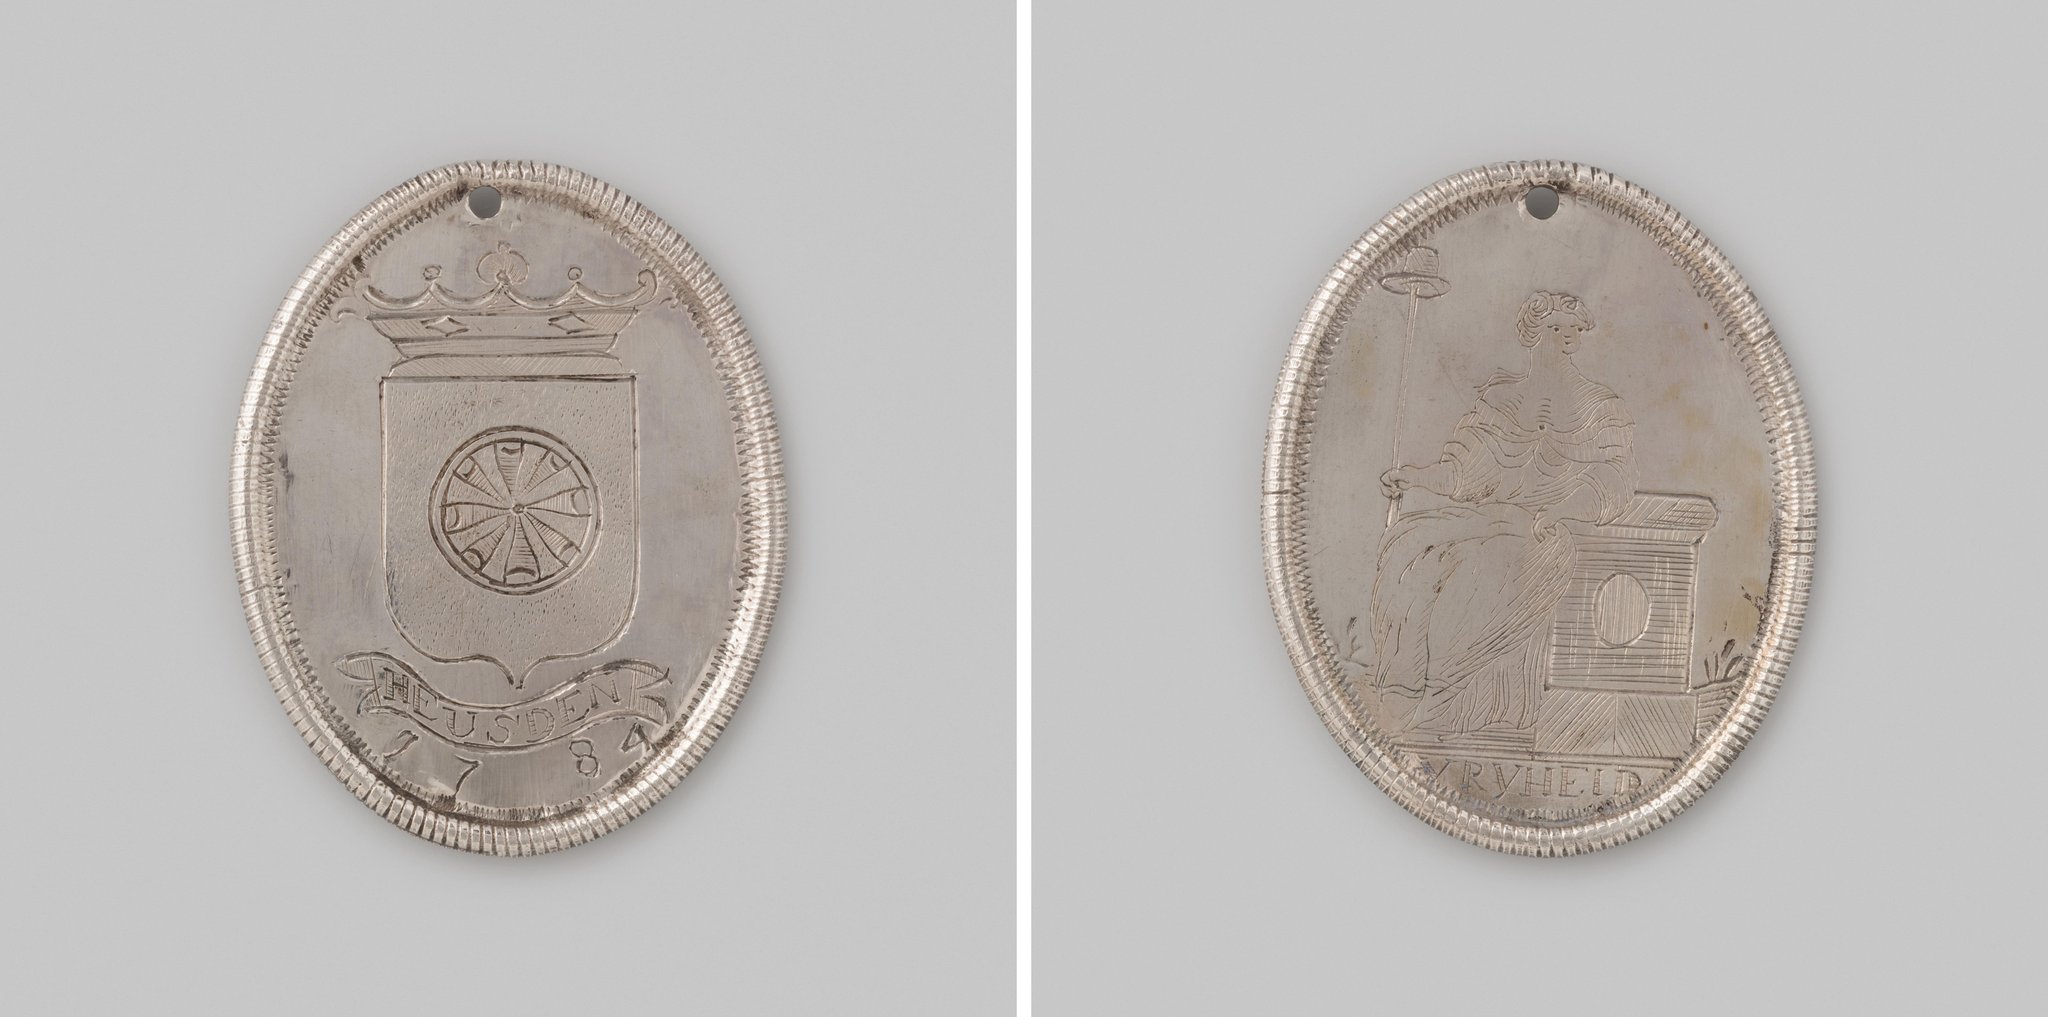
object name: insignia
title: Patriotten te Heusden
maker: Anonymous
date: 1784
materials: silver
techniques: striking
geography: heusden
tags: patriots (1780-1795)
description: Zilveren ovale draagteken met gat erin. Voorzijde: gekroond wapenschild boven wimpel met opschrift en jaartal binnen kabelrand. Keerzijde: vrouw, voorstellende Vrijheid, met hoed op speer, zittend naast altaar; afsnede: opschrift.